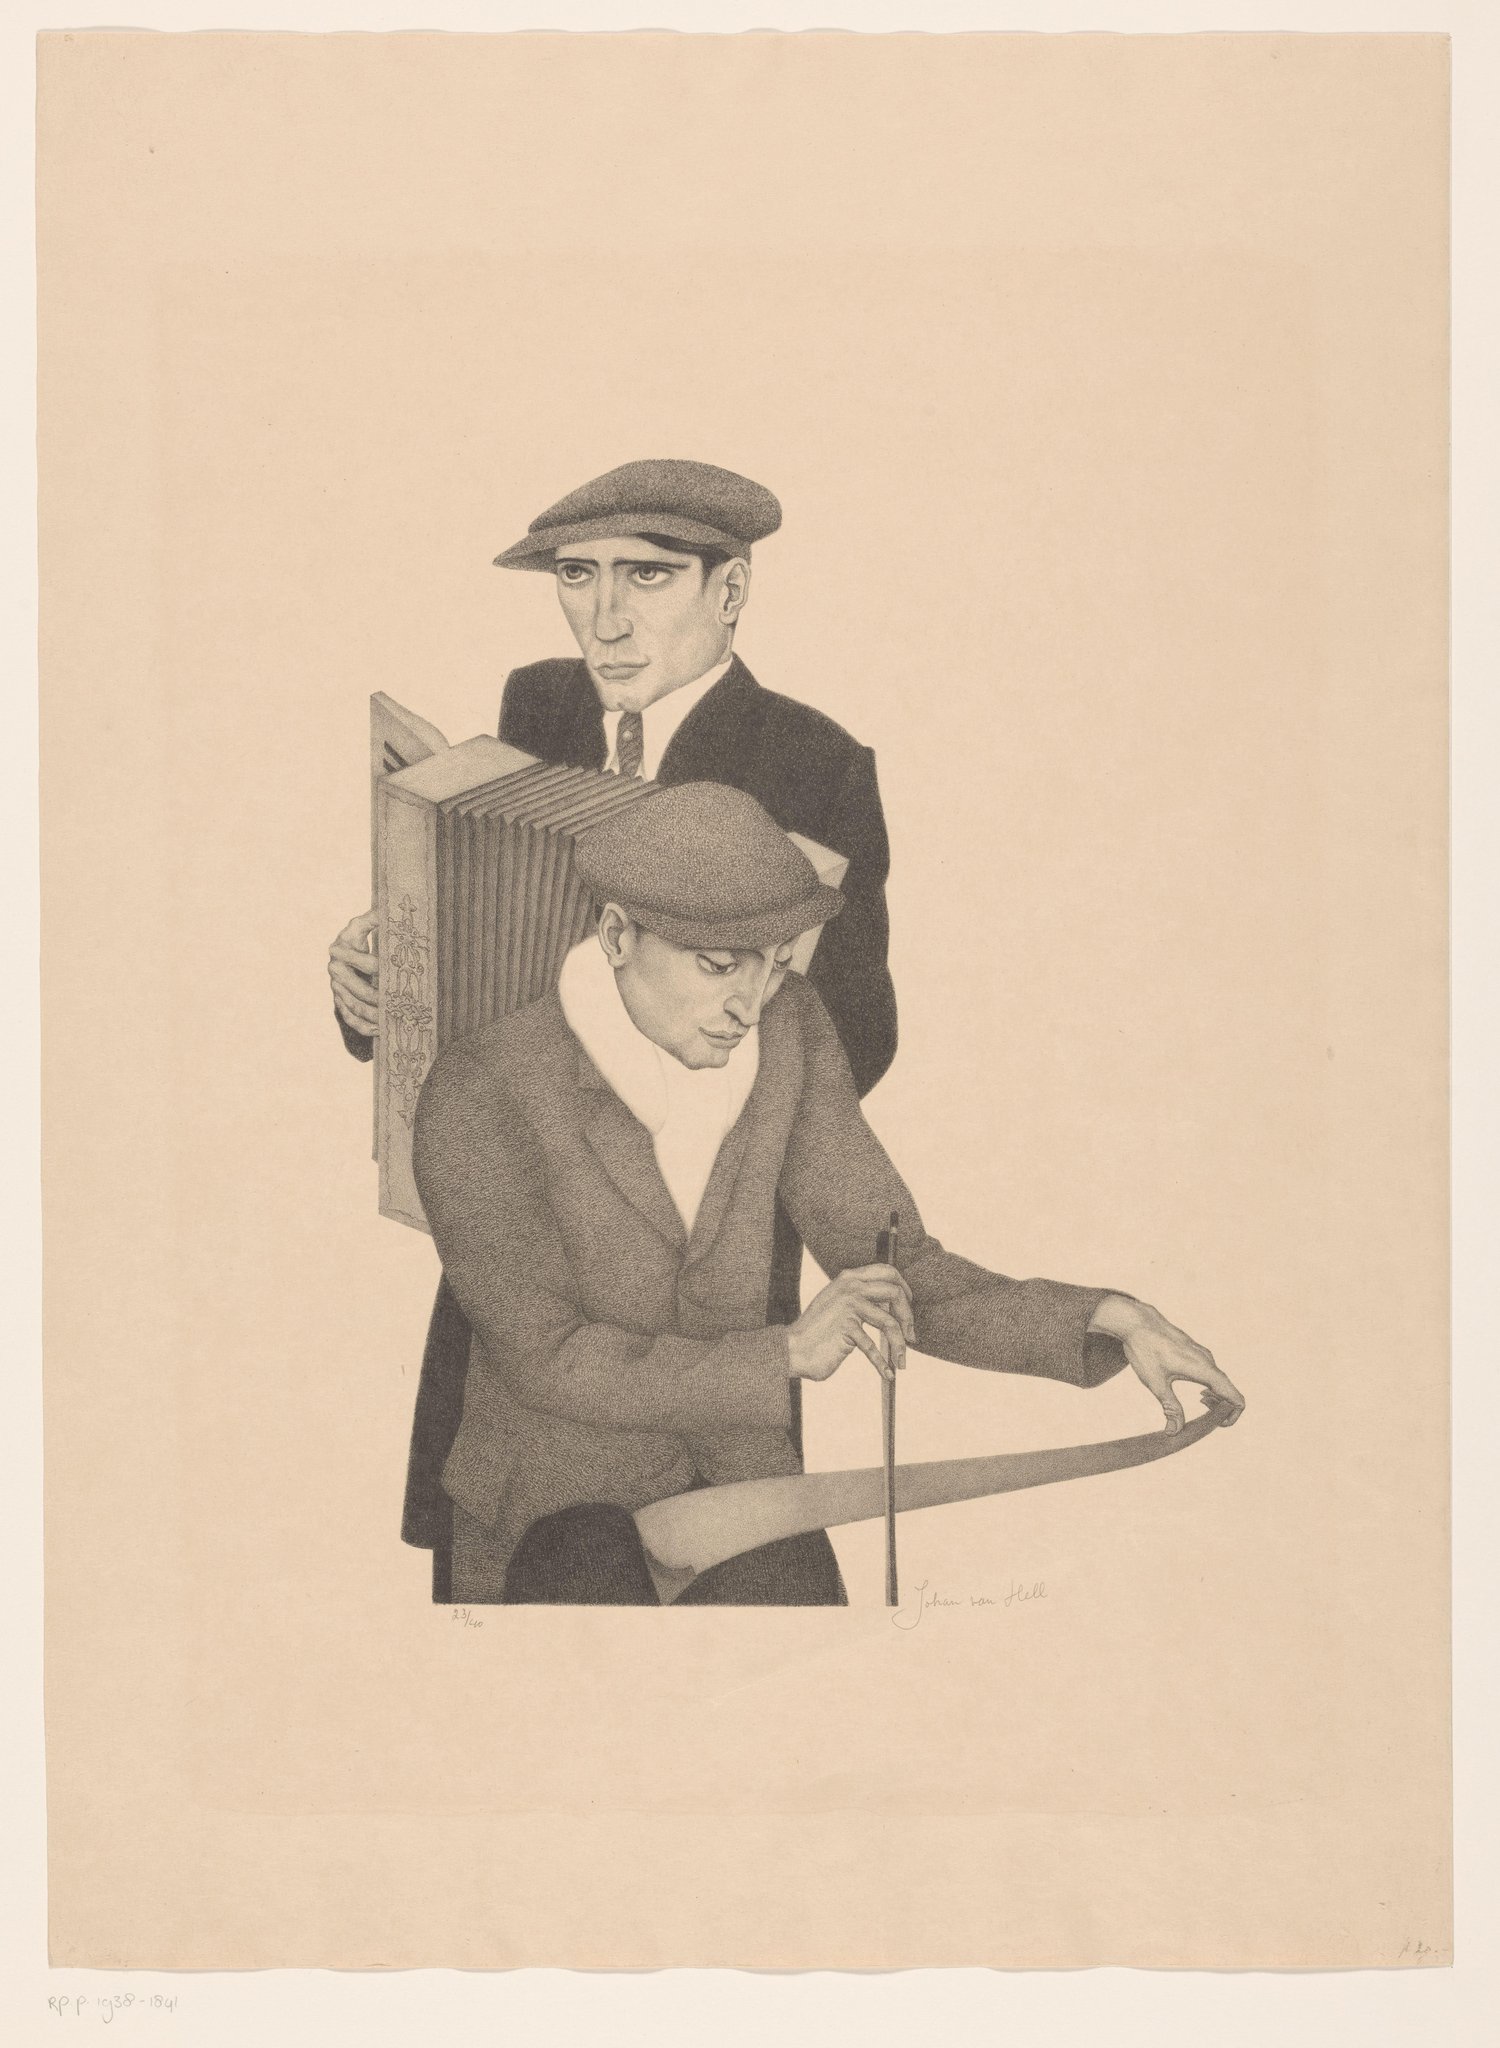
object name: print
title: Zingende zaag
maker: johan van hell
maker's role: print maker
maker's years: 1889-1952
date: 1899-1938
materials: paper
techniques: lithograph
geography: amsterdam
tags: accordion, popular music, street music, more than one musician with instrument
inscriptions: collector's mark: Lugt 2228